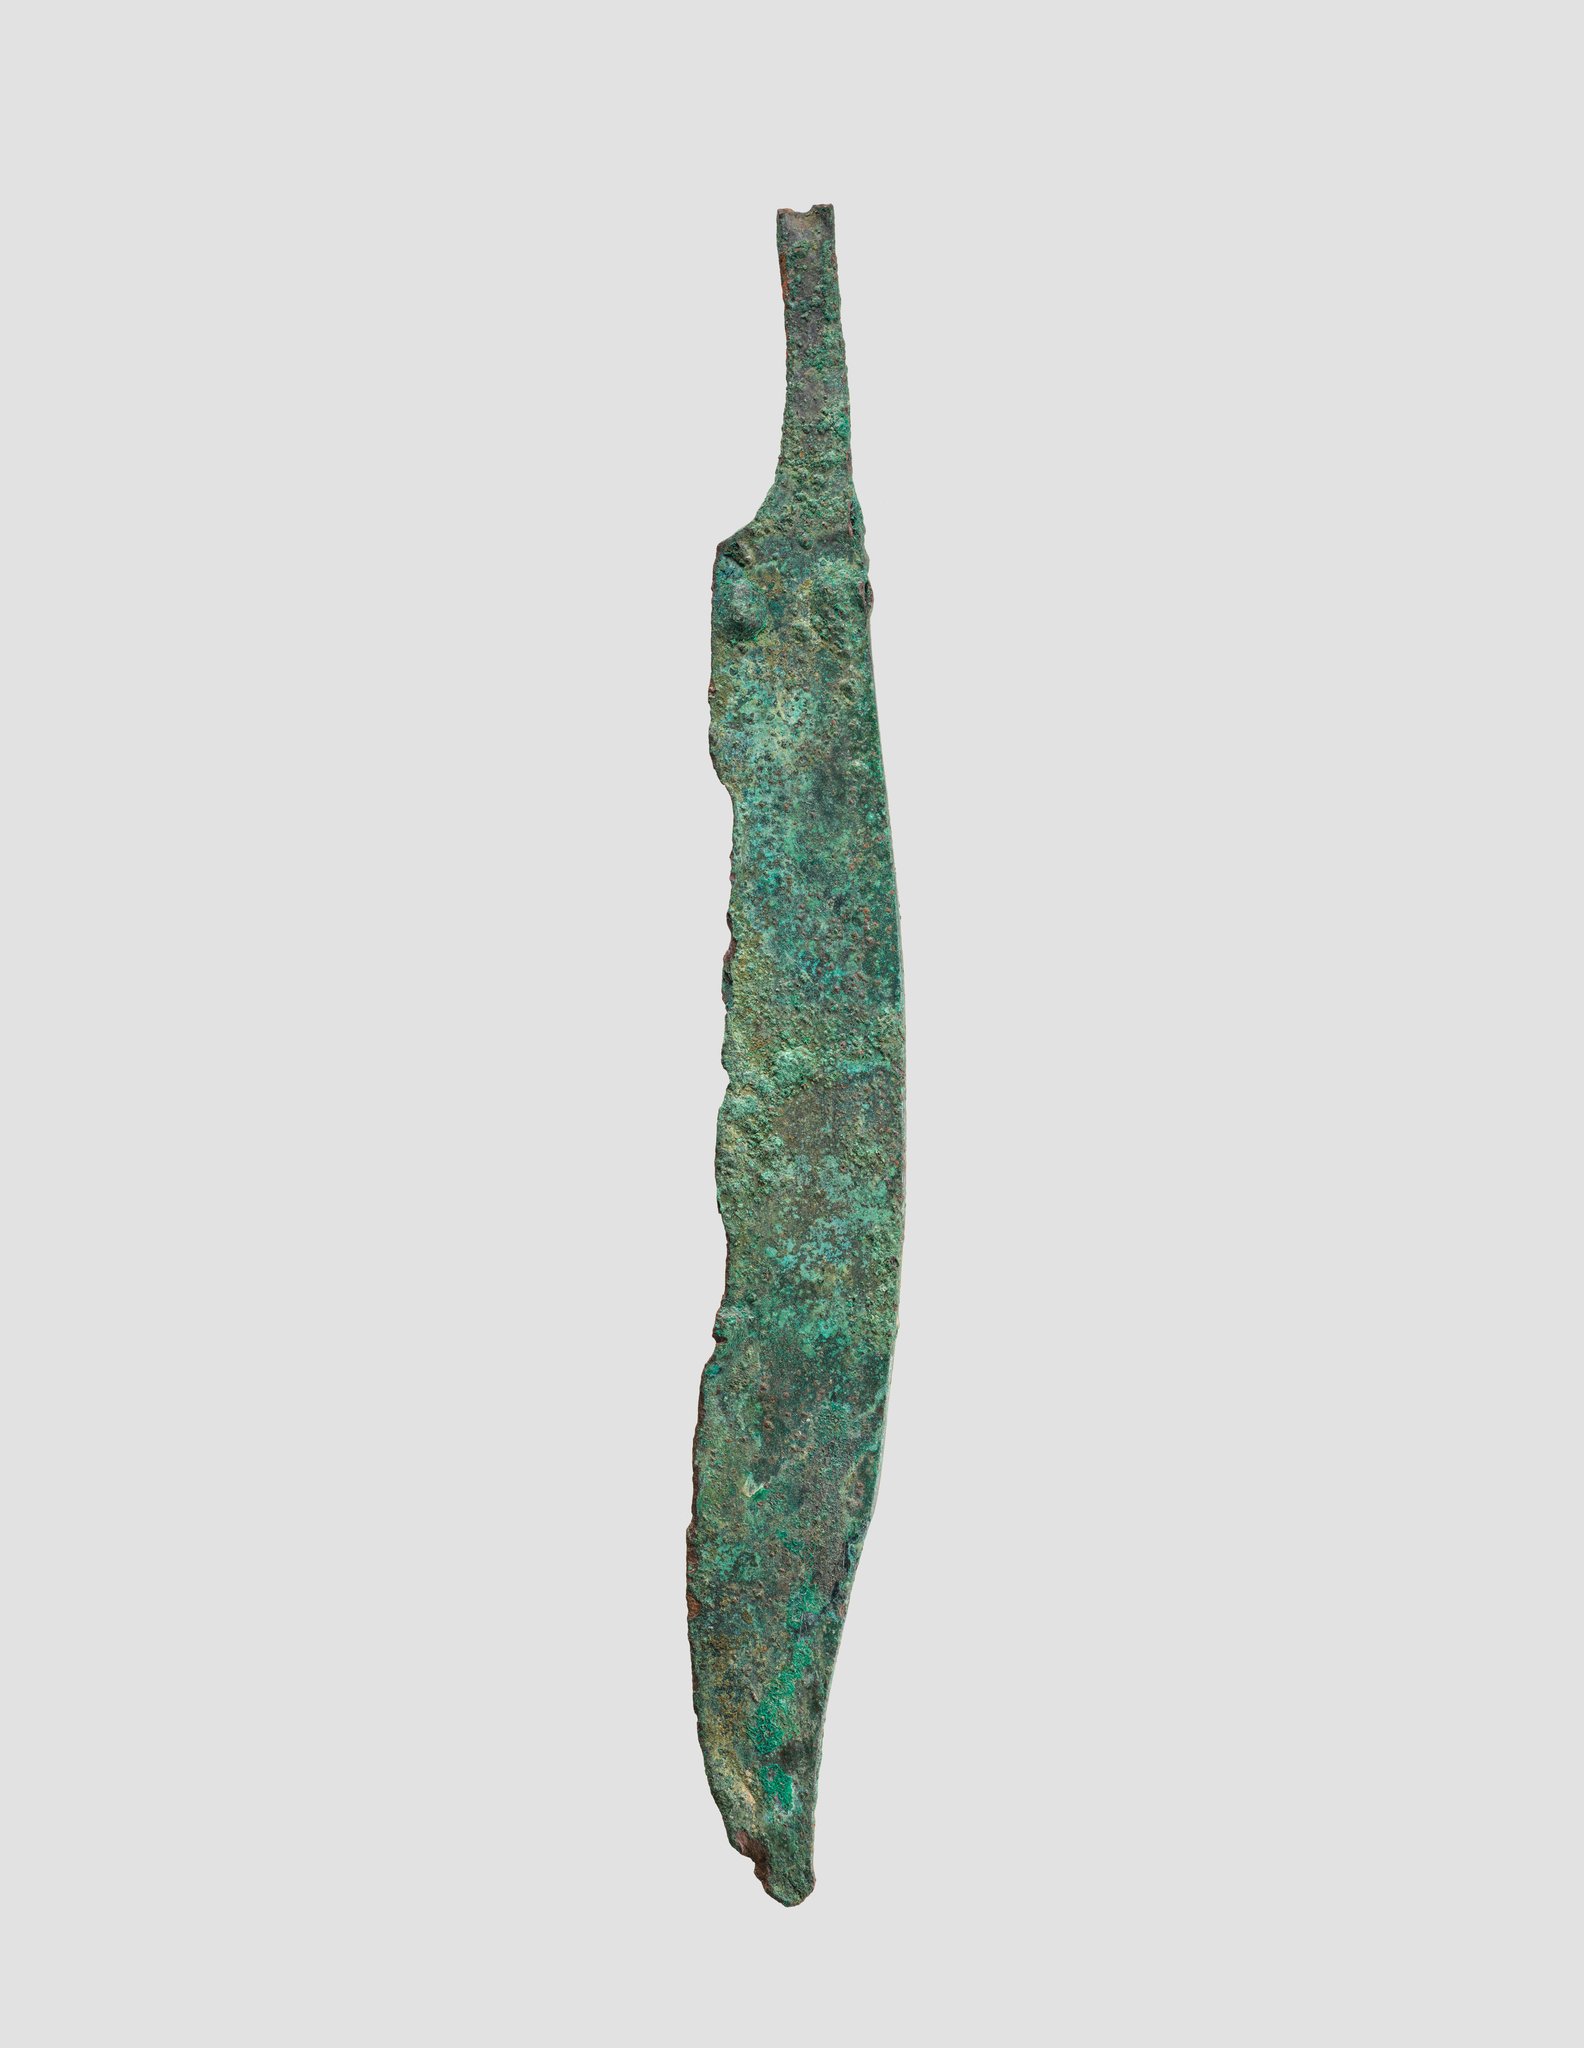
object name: knife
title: Blade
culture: iranian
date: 900-801 BCE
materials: bronze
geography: northwestern iran